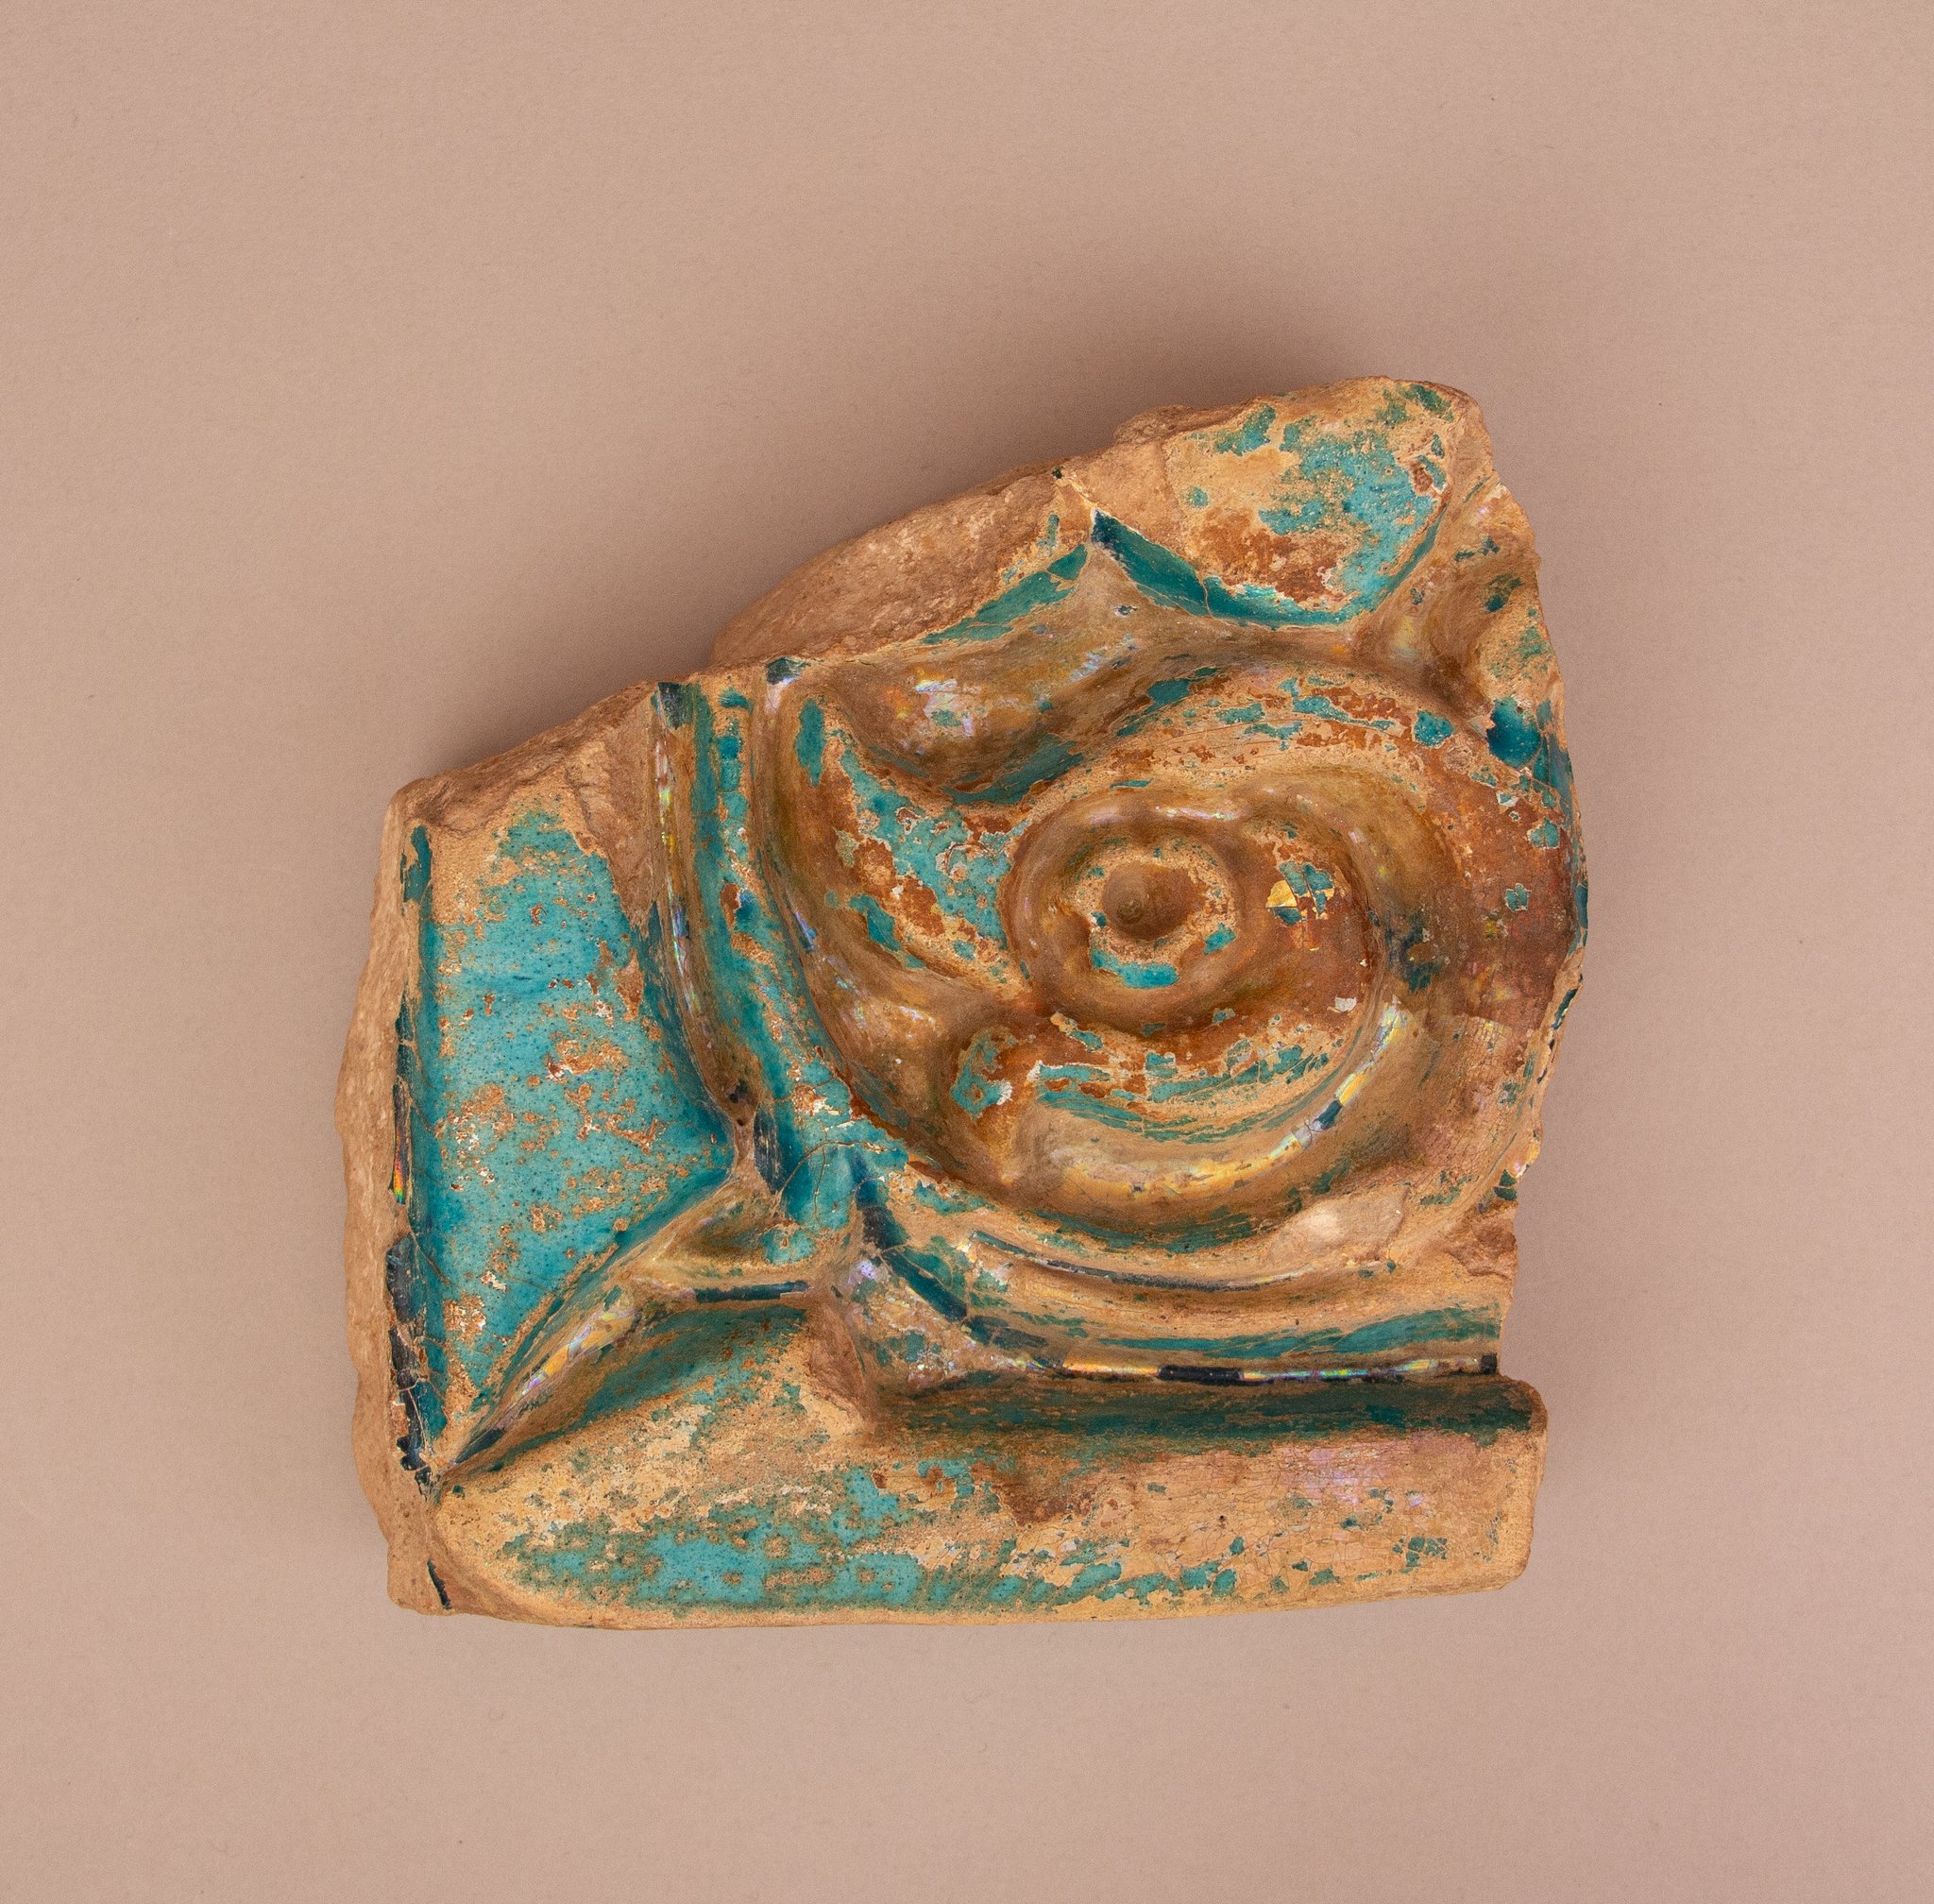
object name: mold fragment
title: Fragment of a Carved or Molded and Glazed Tile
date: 1101-1200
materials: earthenware, glaze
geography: iran